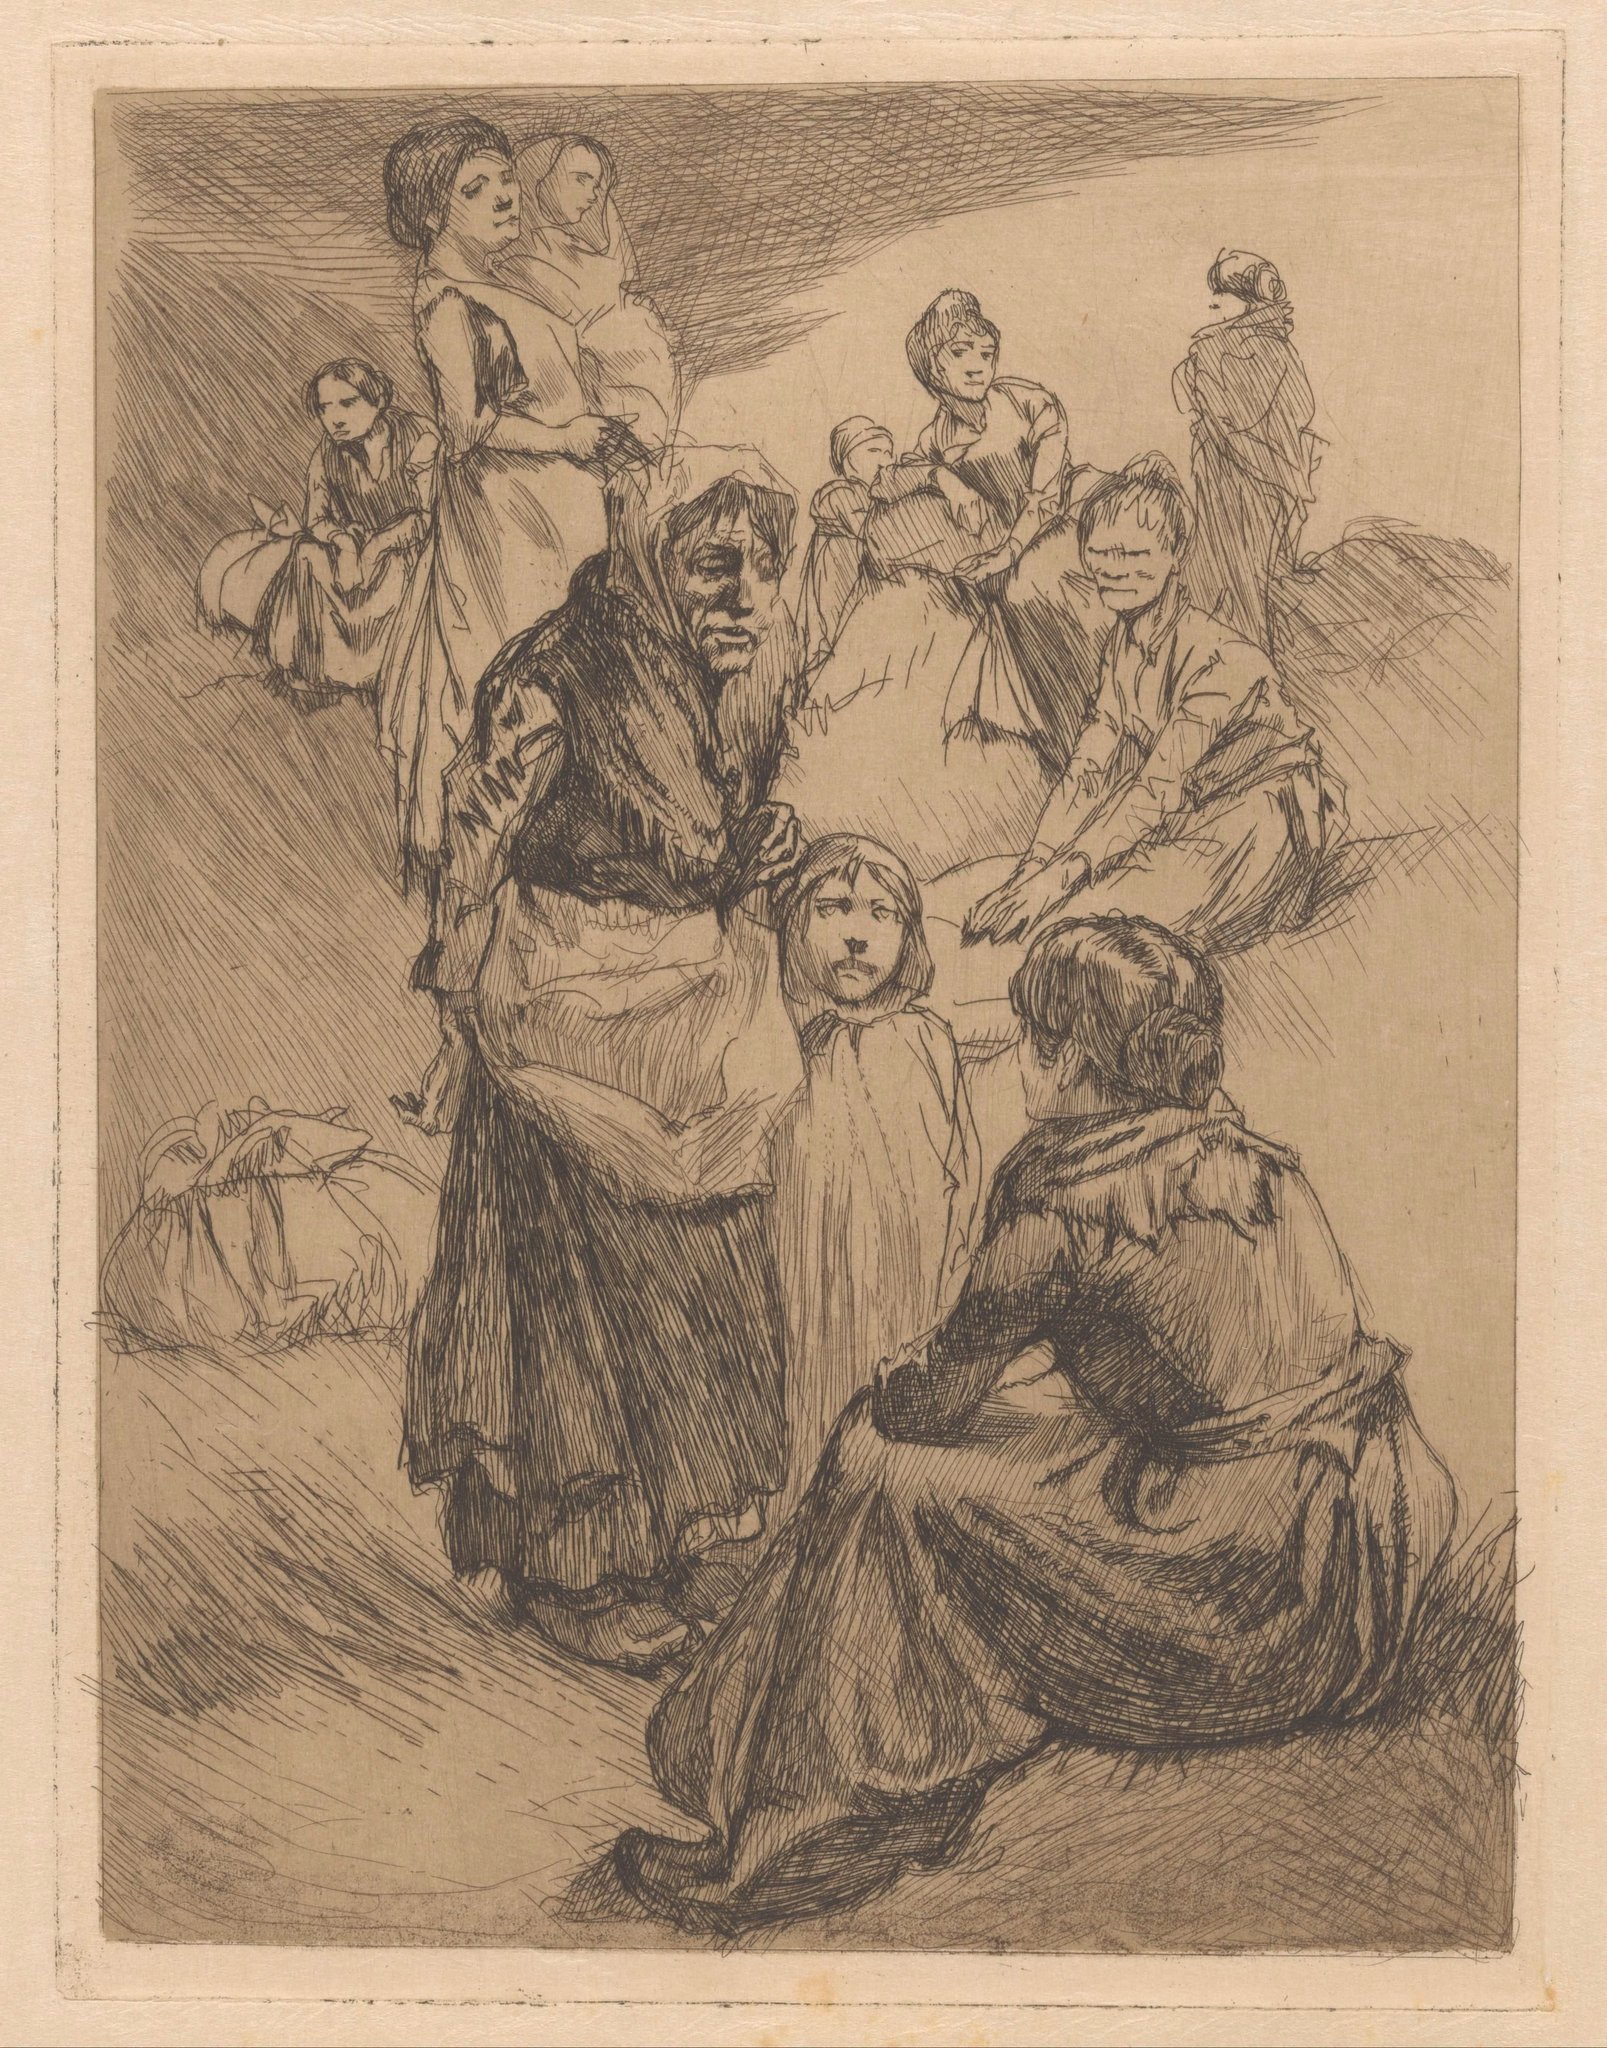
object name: print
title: Volkstypen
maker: johannes josephus aarts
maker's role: draughtsman, print maker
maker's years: 1871-1934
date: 1881-1934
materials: paper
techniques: etching, intaglio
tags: sitting figure - aa - female human figure, standing figure - aa - female human figure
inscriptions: collector's mark: Lugt 2760, collector's mark: Lugt 2228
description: Tien vrouwen en meisjes bevinden zich, staand en zittend, in een met gras begroeid landschap.